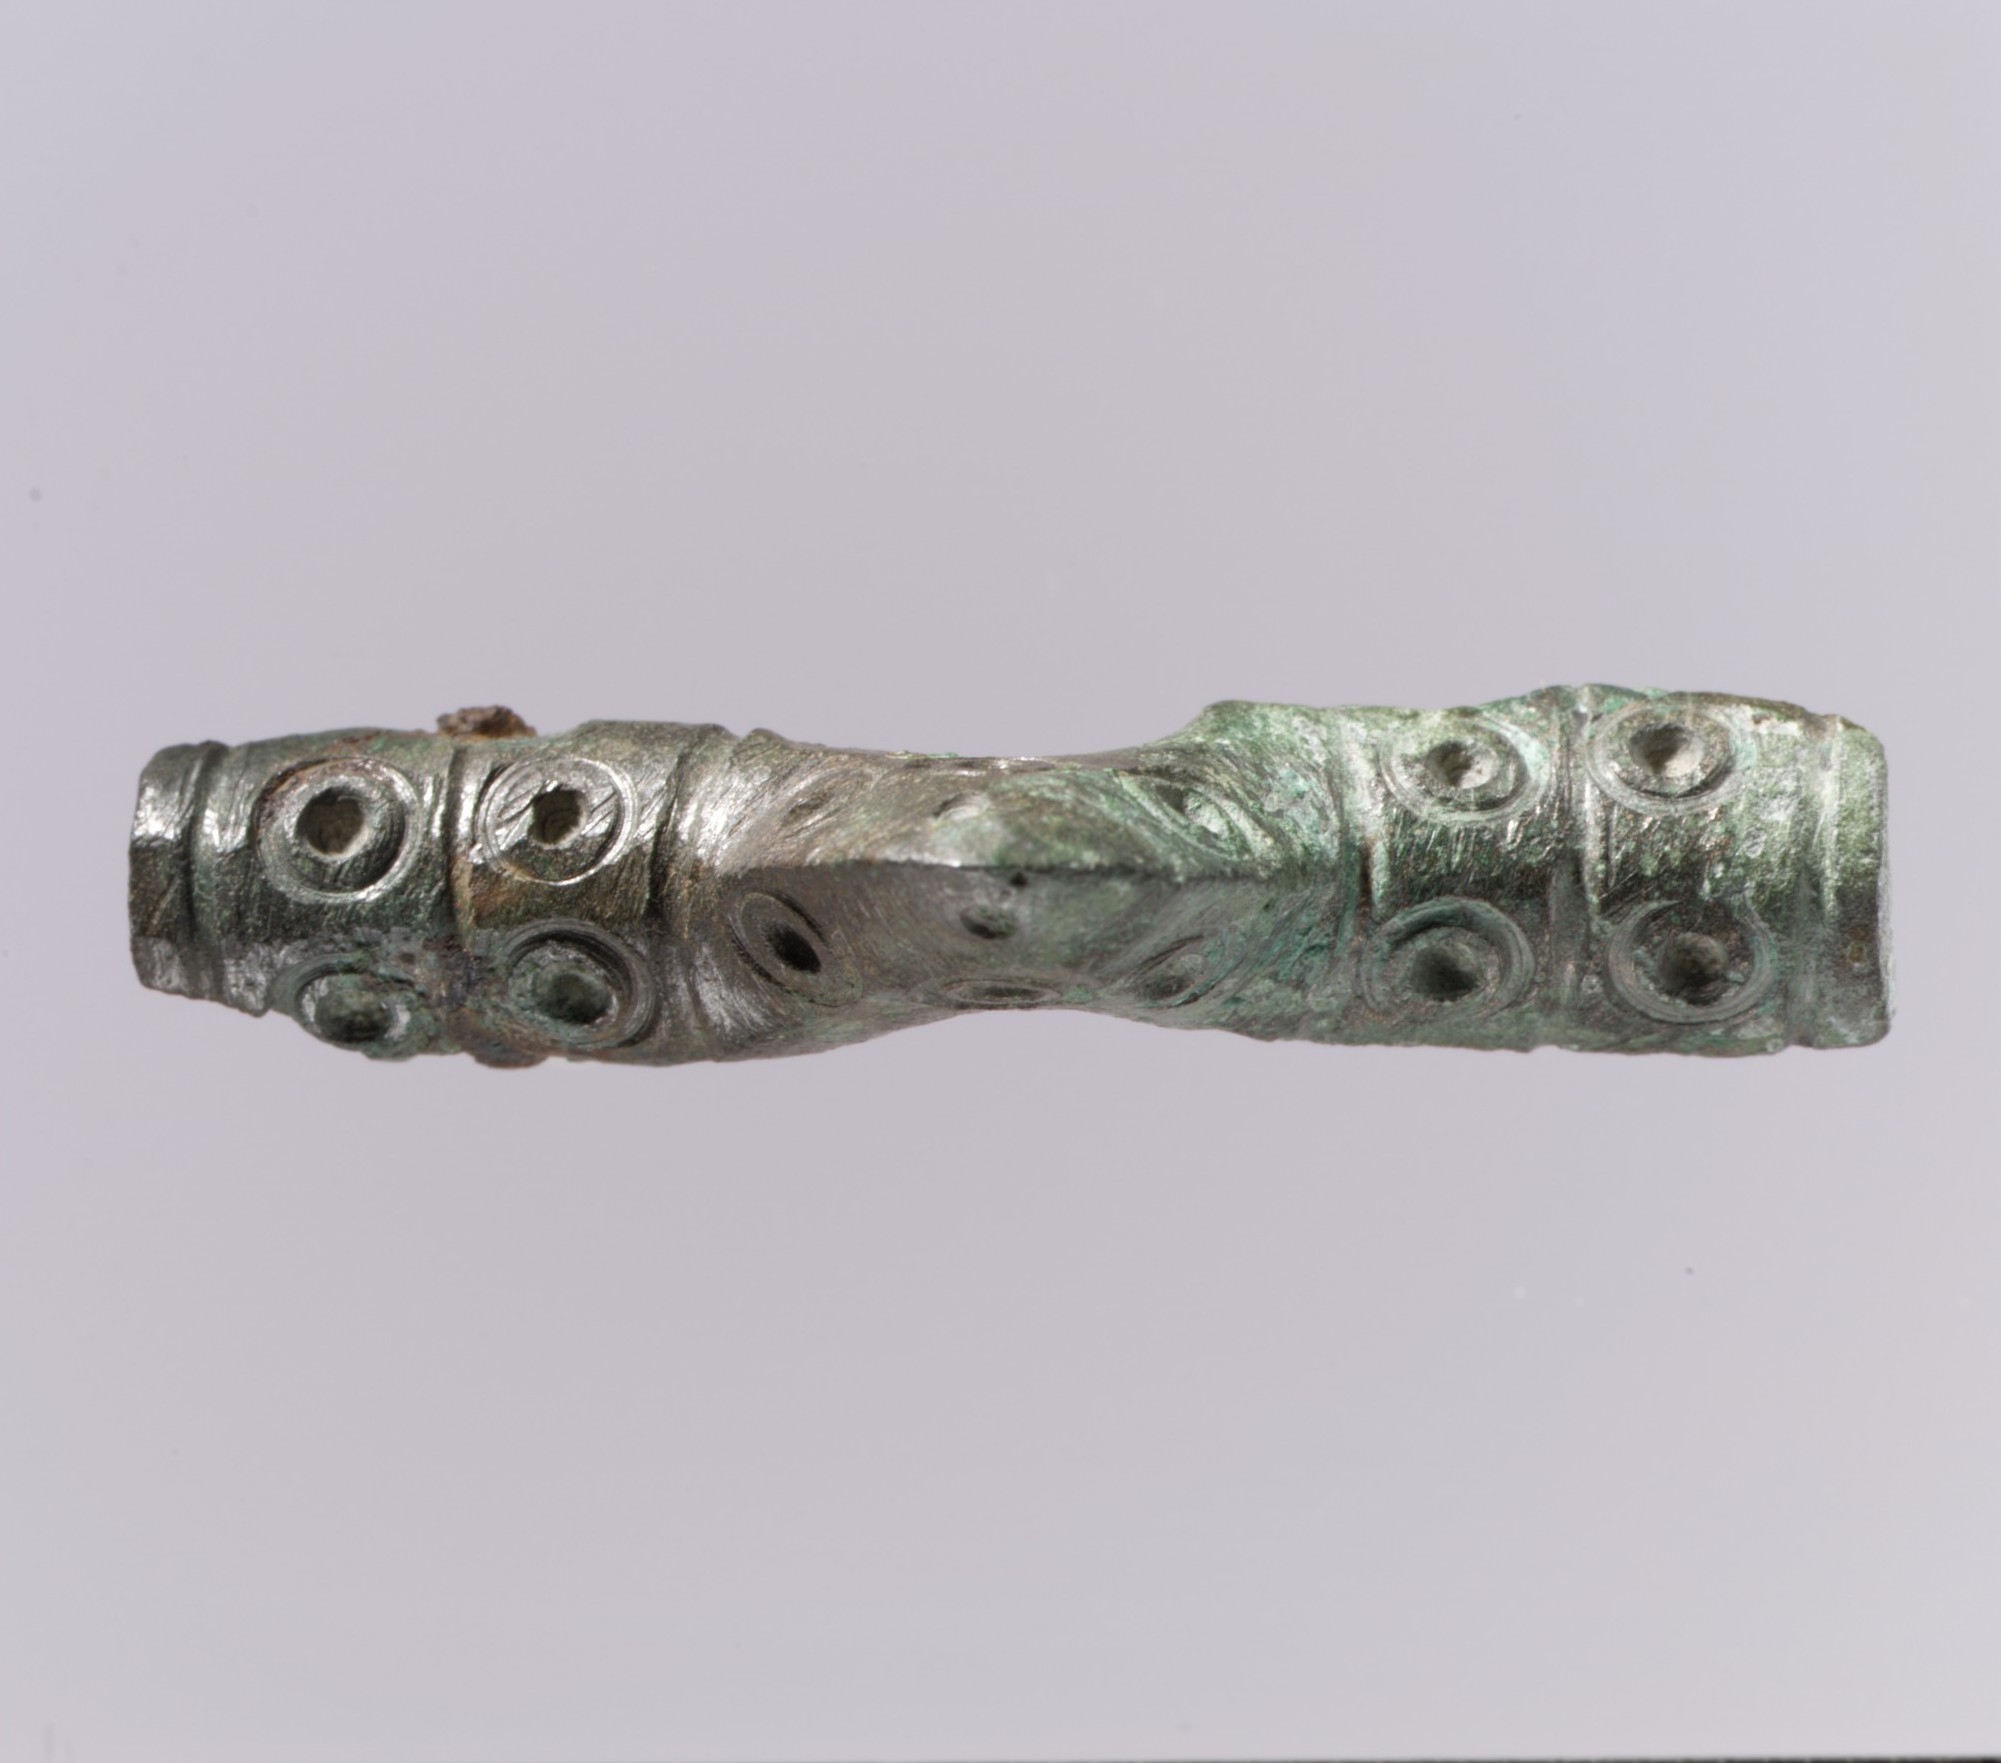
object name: brooch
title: Equal-Arm Brooch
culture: frankish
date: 601-800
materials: copper alloy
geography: northern france